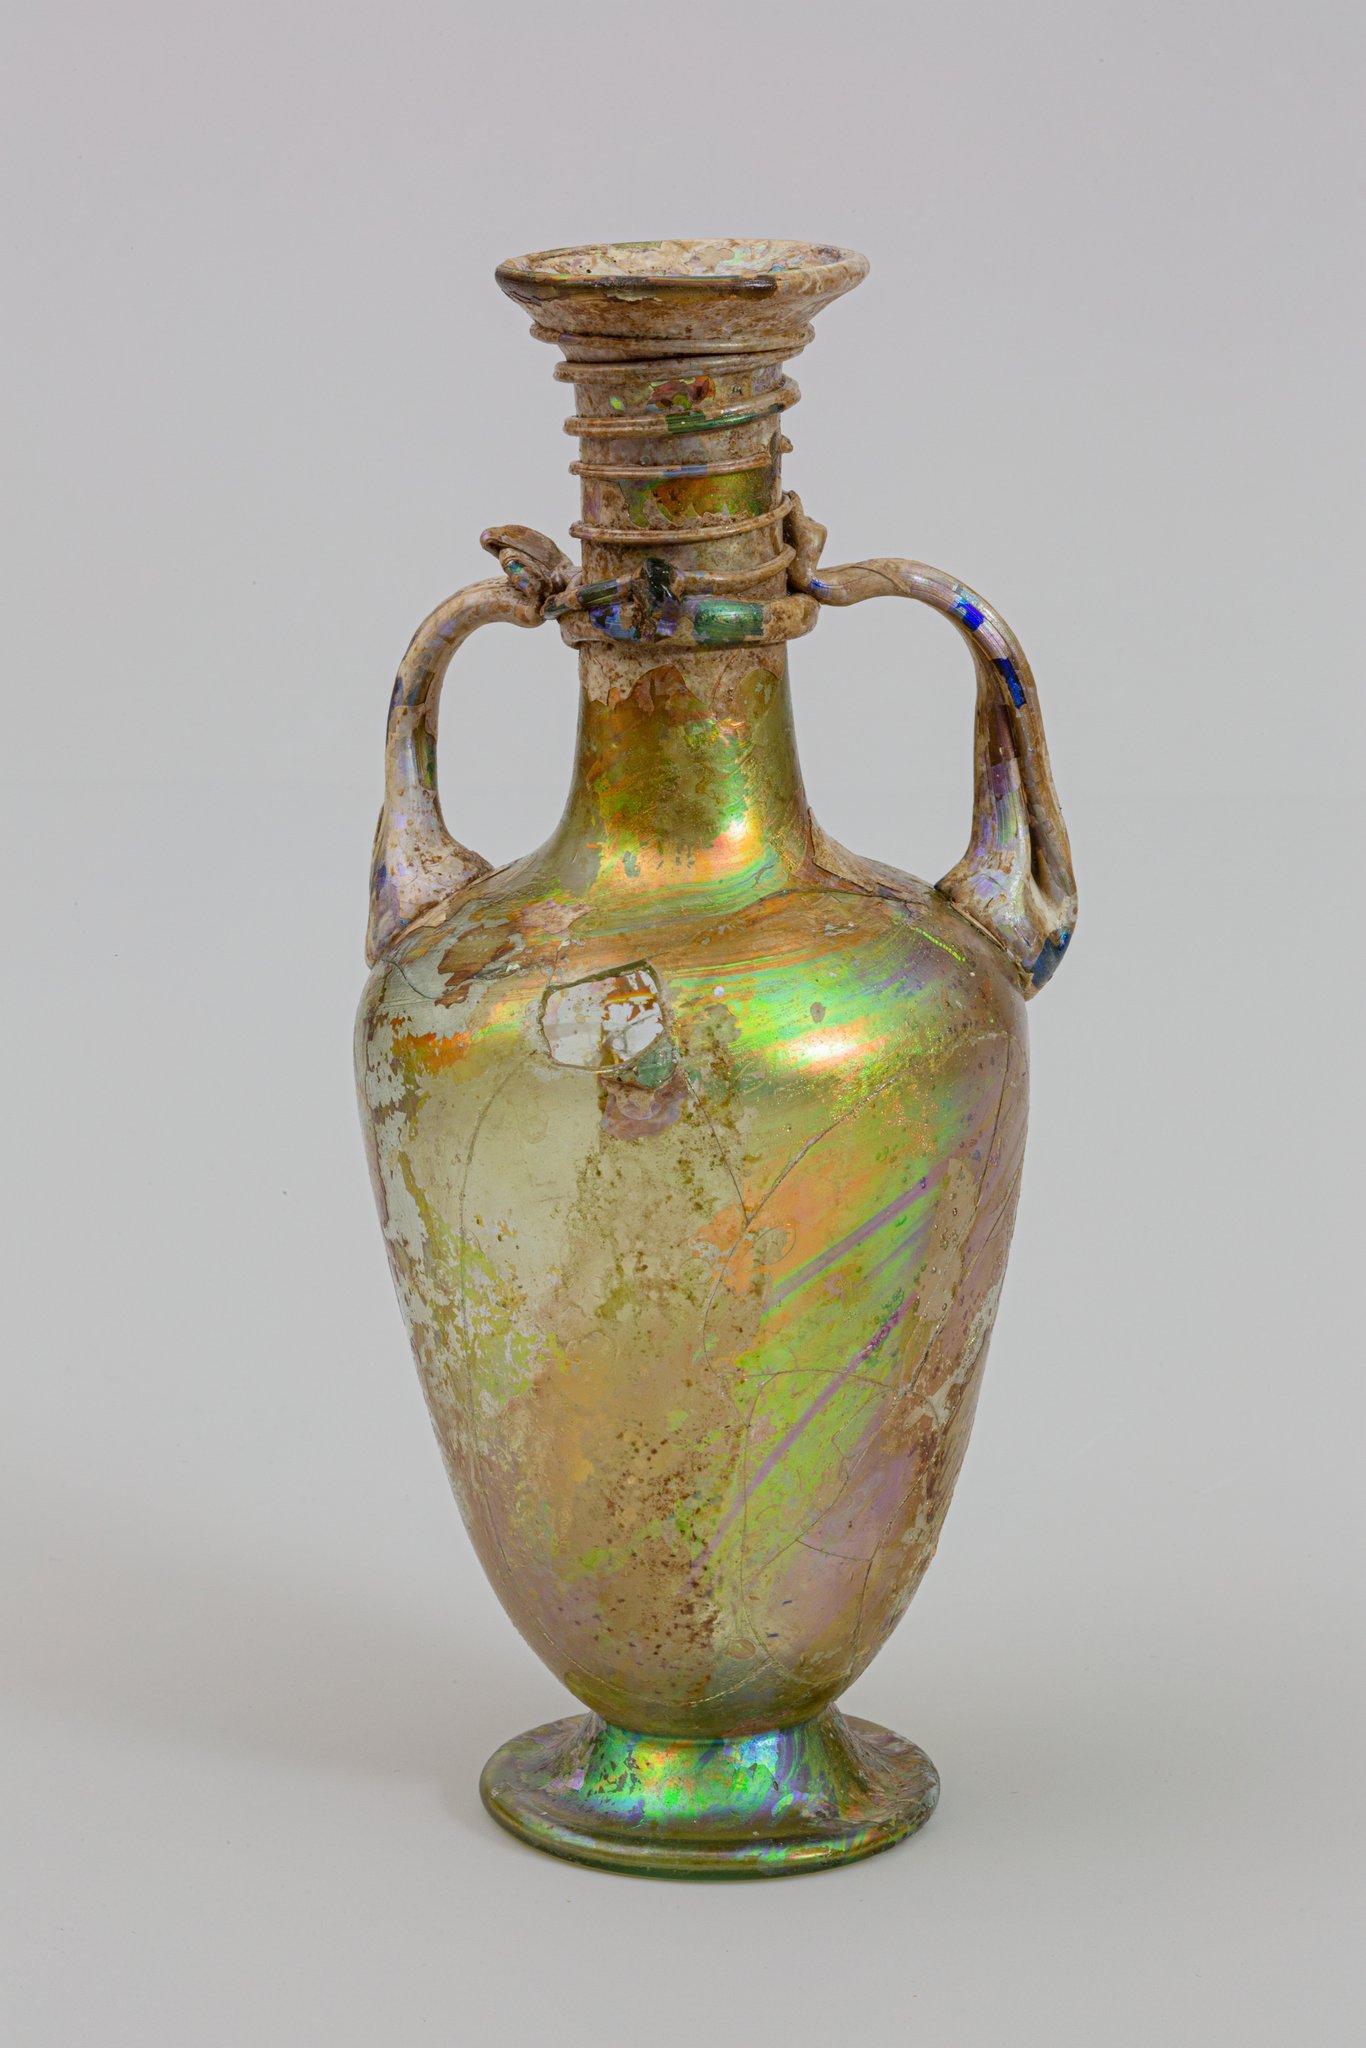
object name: bottle, two handled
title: Glass two-handled bottle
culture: roman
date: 301-400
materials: glass